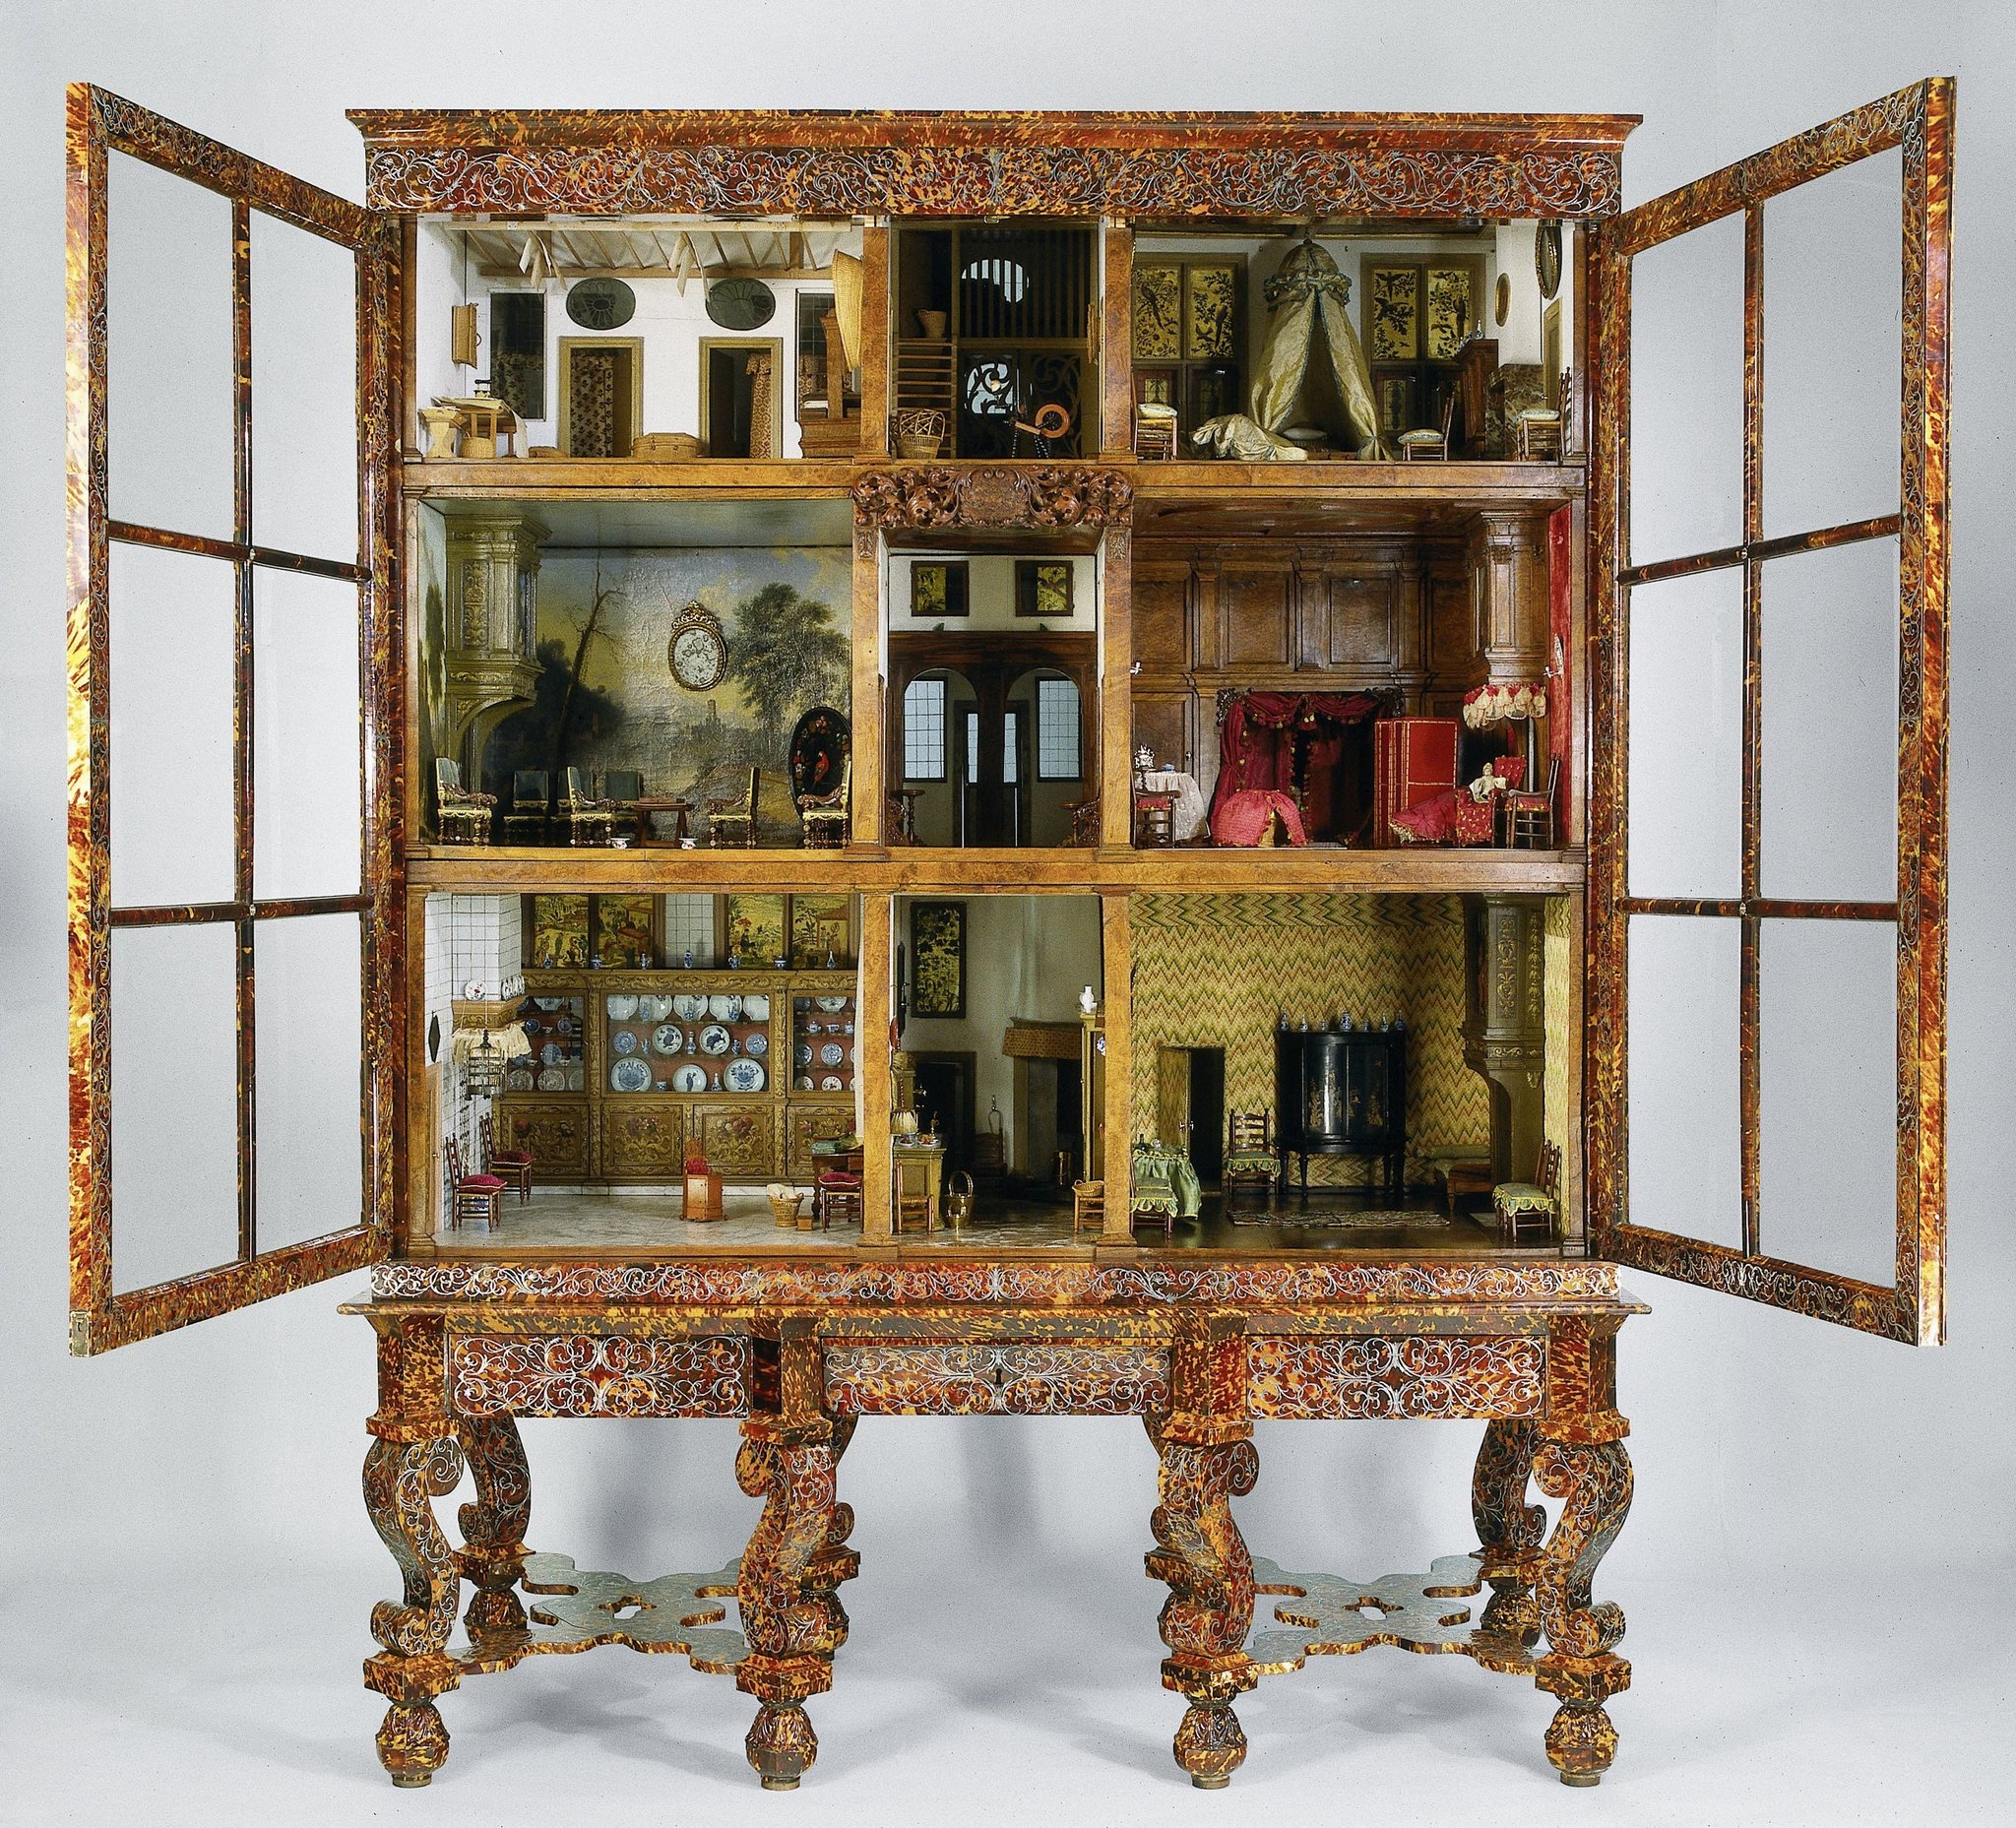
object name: dollhouse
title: Dolls’ house of Petronella Oortman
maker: Anonymous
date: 1686-1710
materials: wood, copper, glass, marble, paper, silk, tin, shell, velvet, yarns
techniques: embroidered, painted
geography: amsterdam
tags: interior of the house, furniture and household effects, picture, painting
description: This dolls’ house is exceptionally realistic. All the contents have been made of authentic materials, and the proportions are exactly correct. The fine cabinet, of tortoiseshell decorated with pewter inlays, was made by a cabinetmaker from France, who worked in Amsterdam for several years. Petronella Oortman was married to the Amsterdam merchant Johannes Brandt.